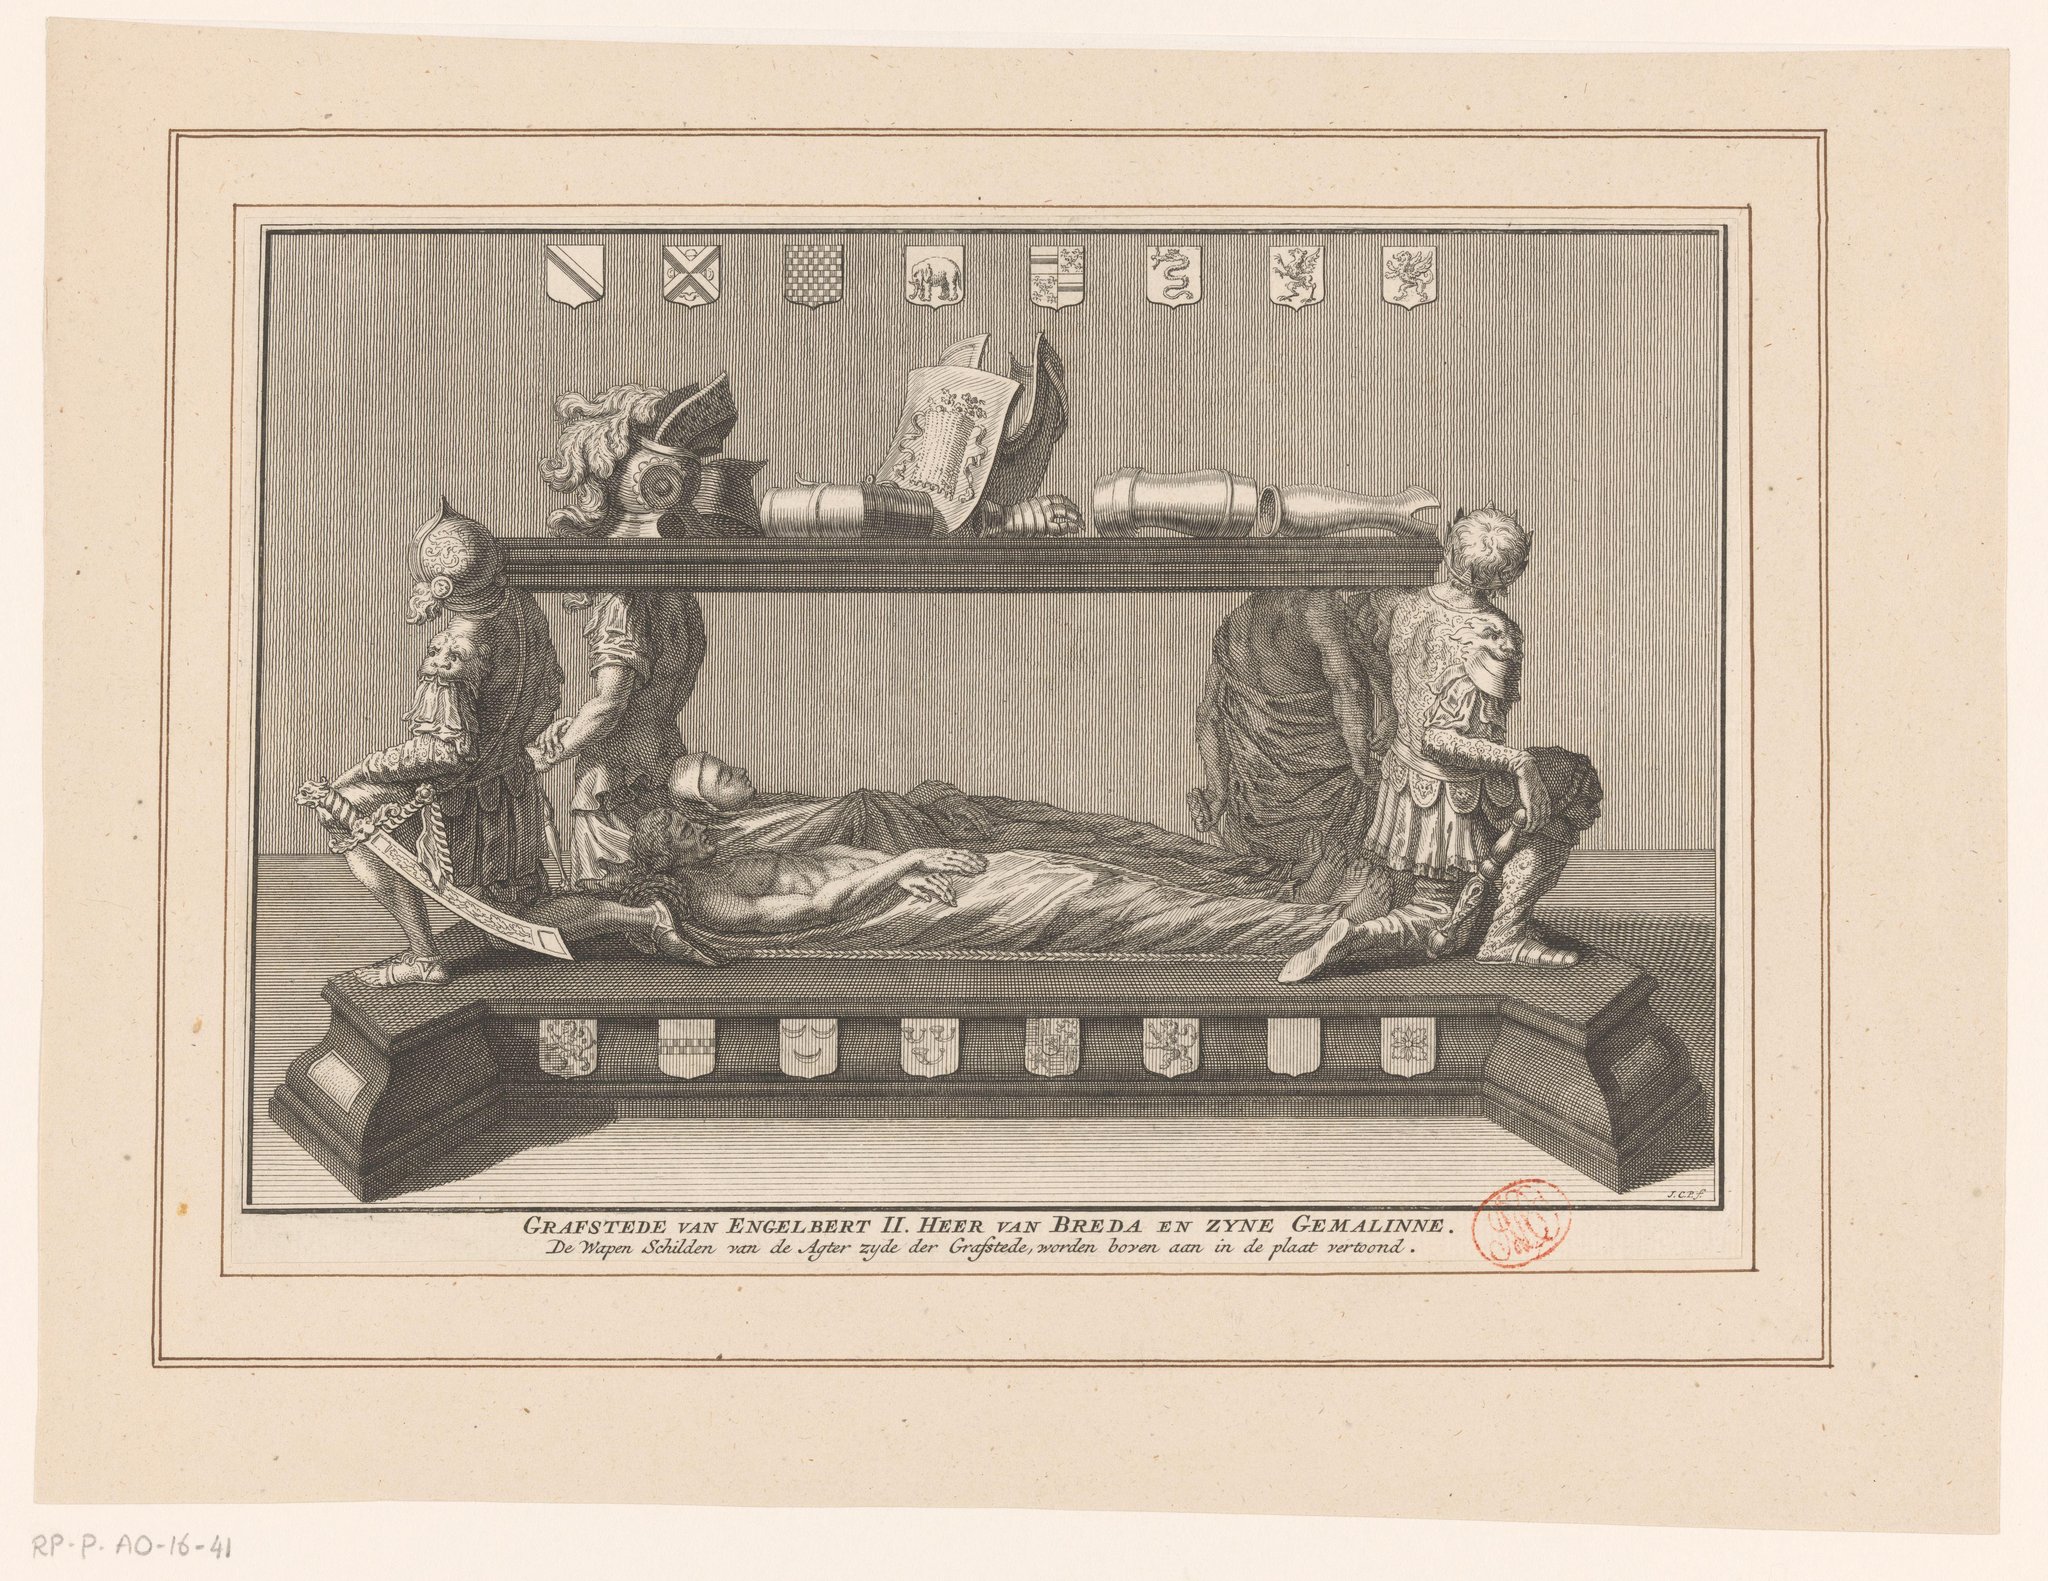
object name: book illustration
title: Grafstede van Engelbert II. Heer van Breda en zyne Gemalinne. De wapen schilden van de agter zyde der grafstede, worden boven aan in de plaat vertoond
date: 1740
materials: paper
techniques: engraving, etching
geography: amsterdam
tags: grave, tomb, armorial bearing, heraldry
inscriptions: collector's mark: Lugt 195, collector's mark: Lugt 2228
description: Prent ook gebruikt in: Wagenaar, Jan. Tegenwoordige staat der Vereenigde Nederlanden, tweede deel. Vervattende eene beschryving der Generaliteits Landen (…) / Hedendaagsche historie, of tegenwoordige staat van alle volkeren; twaalfde deel (…). Amsterdam: Isaak Tirion, 1740, p. 216.